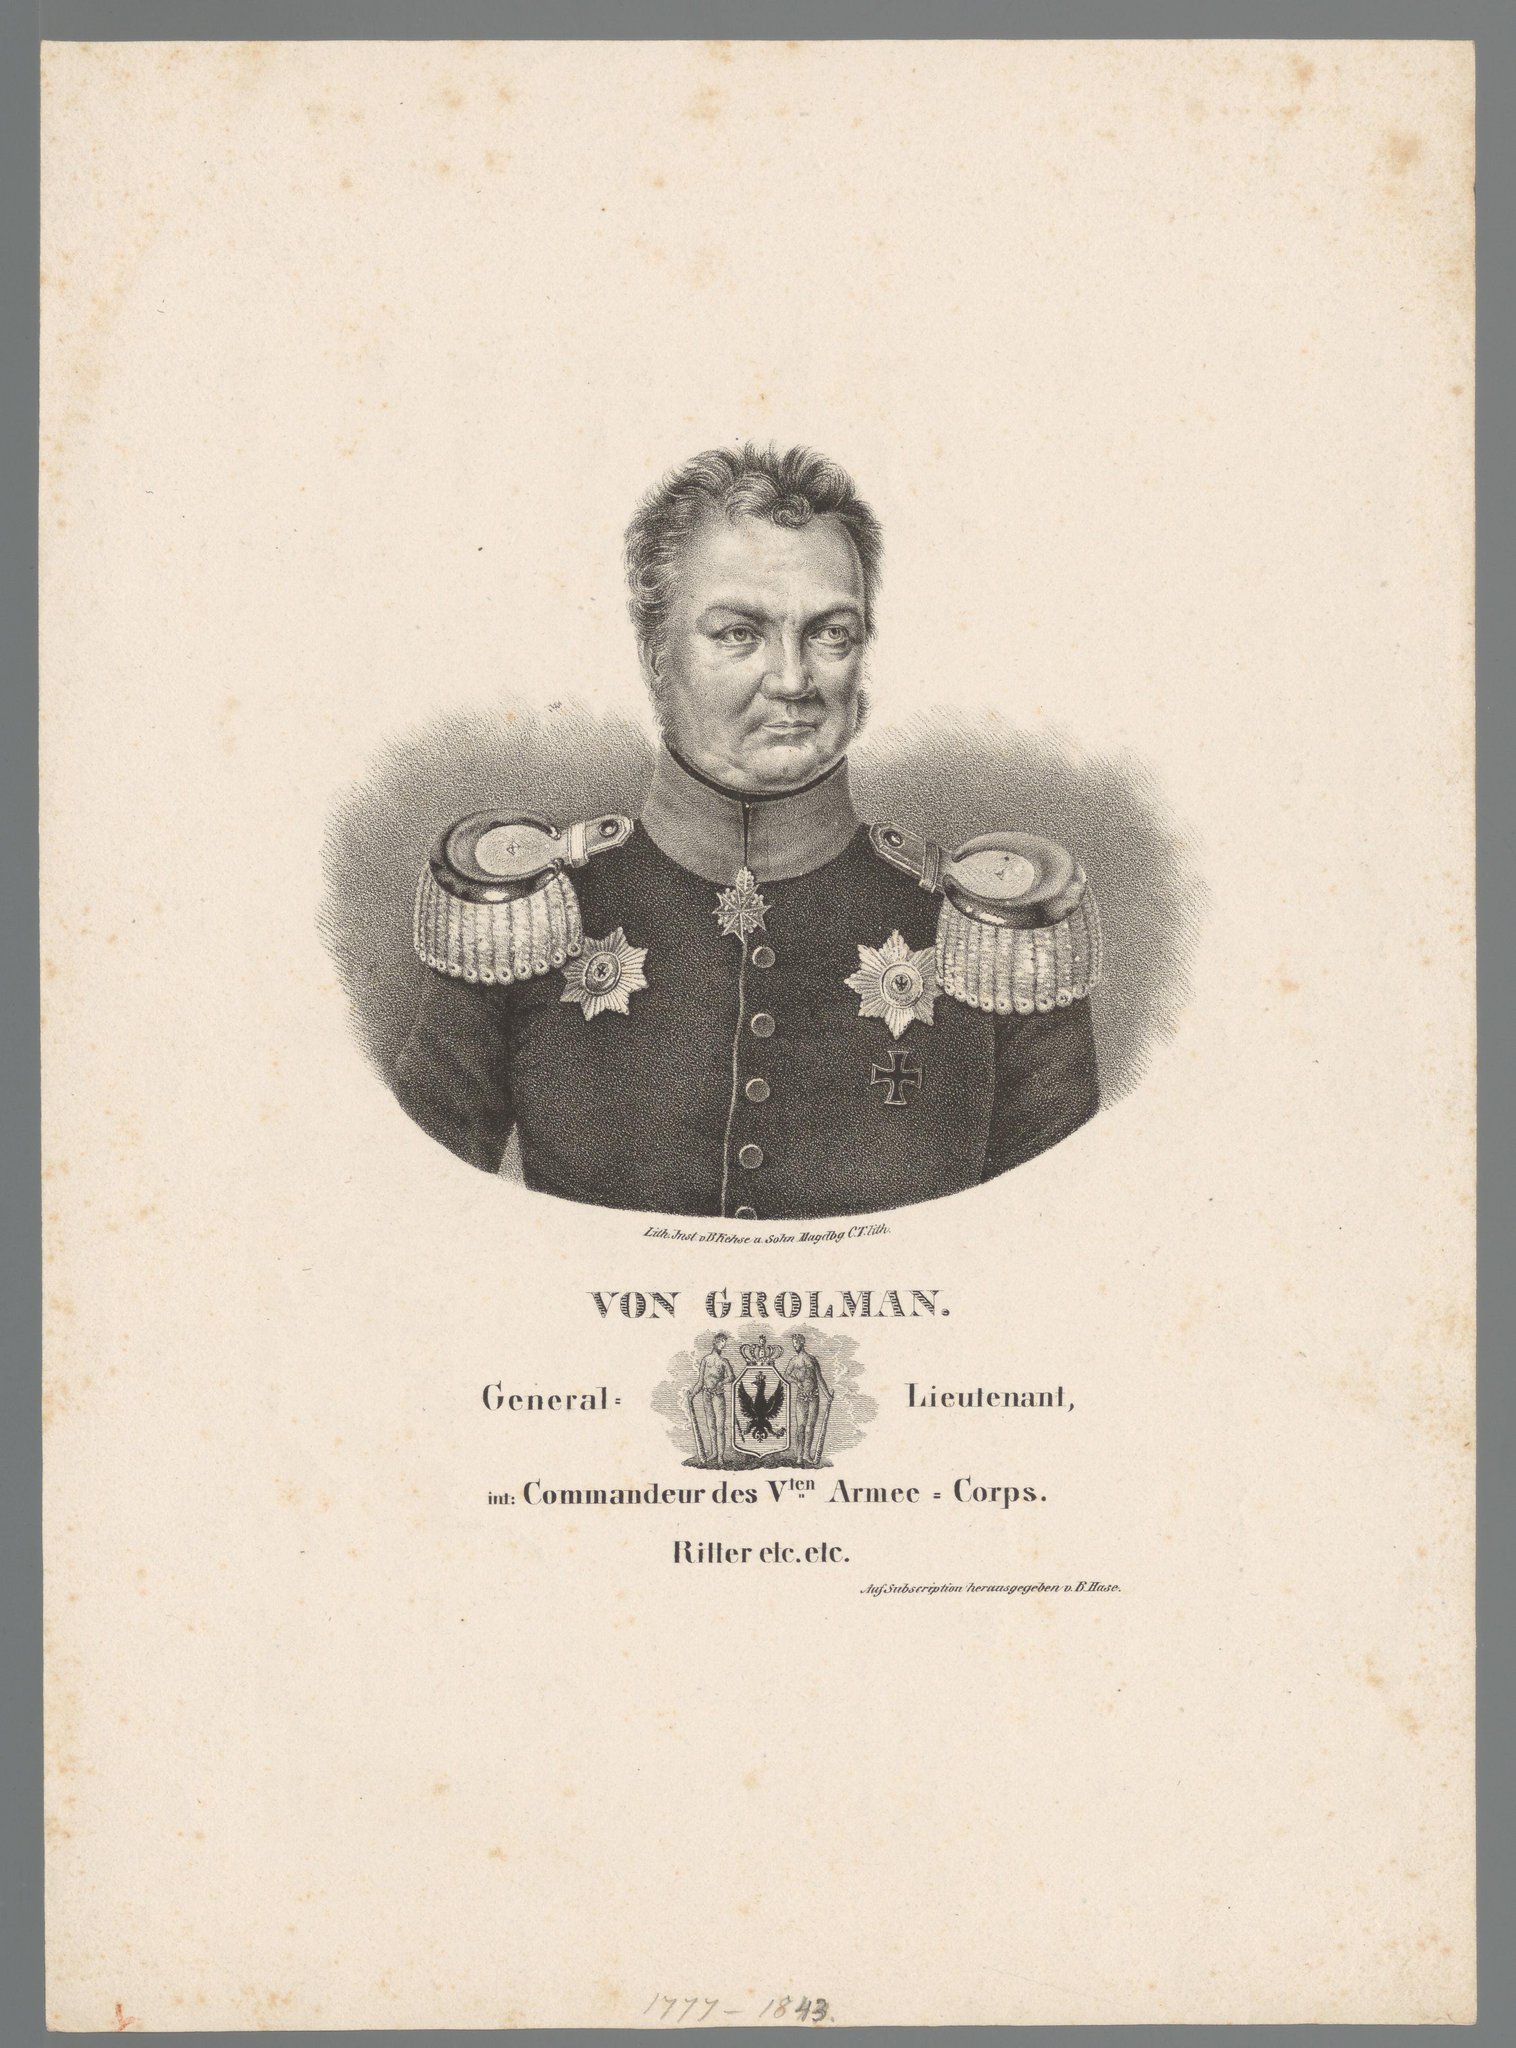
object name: print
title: Portret van Karl von Grolman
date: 1830-1850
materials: paper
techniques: lithograph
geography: magdeburg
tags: berlin, adult man, historical persons, (military) uniforms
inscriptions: collector's mark: Lugt 2228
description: Midden onder staat het wapen van Pruisen.